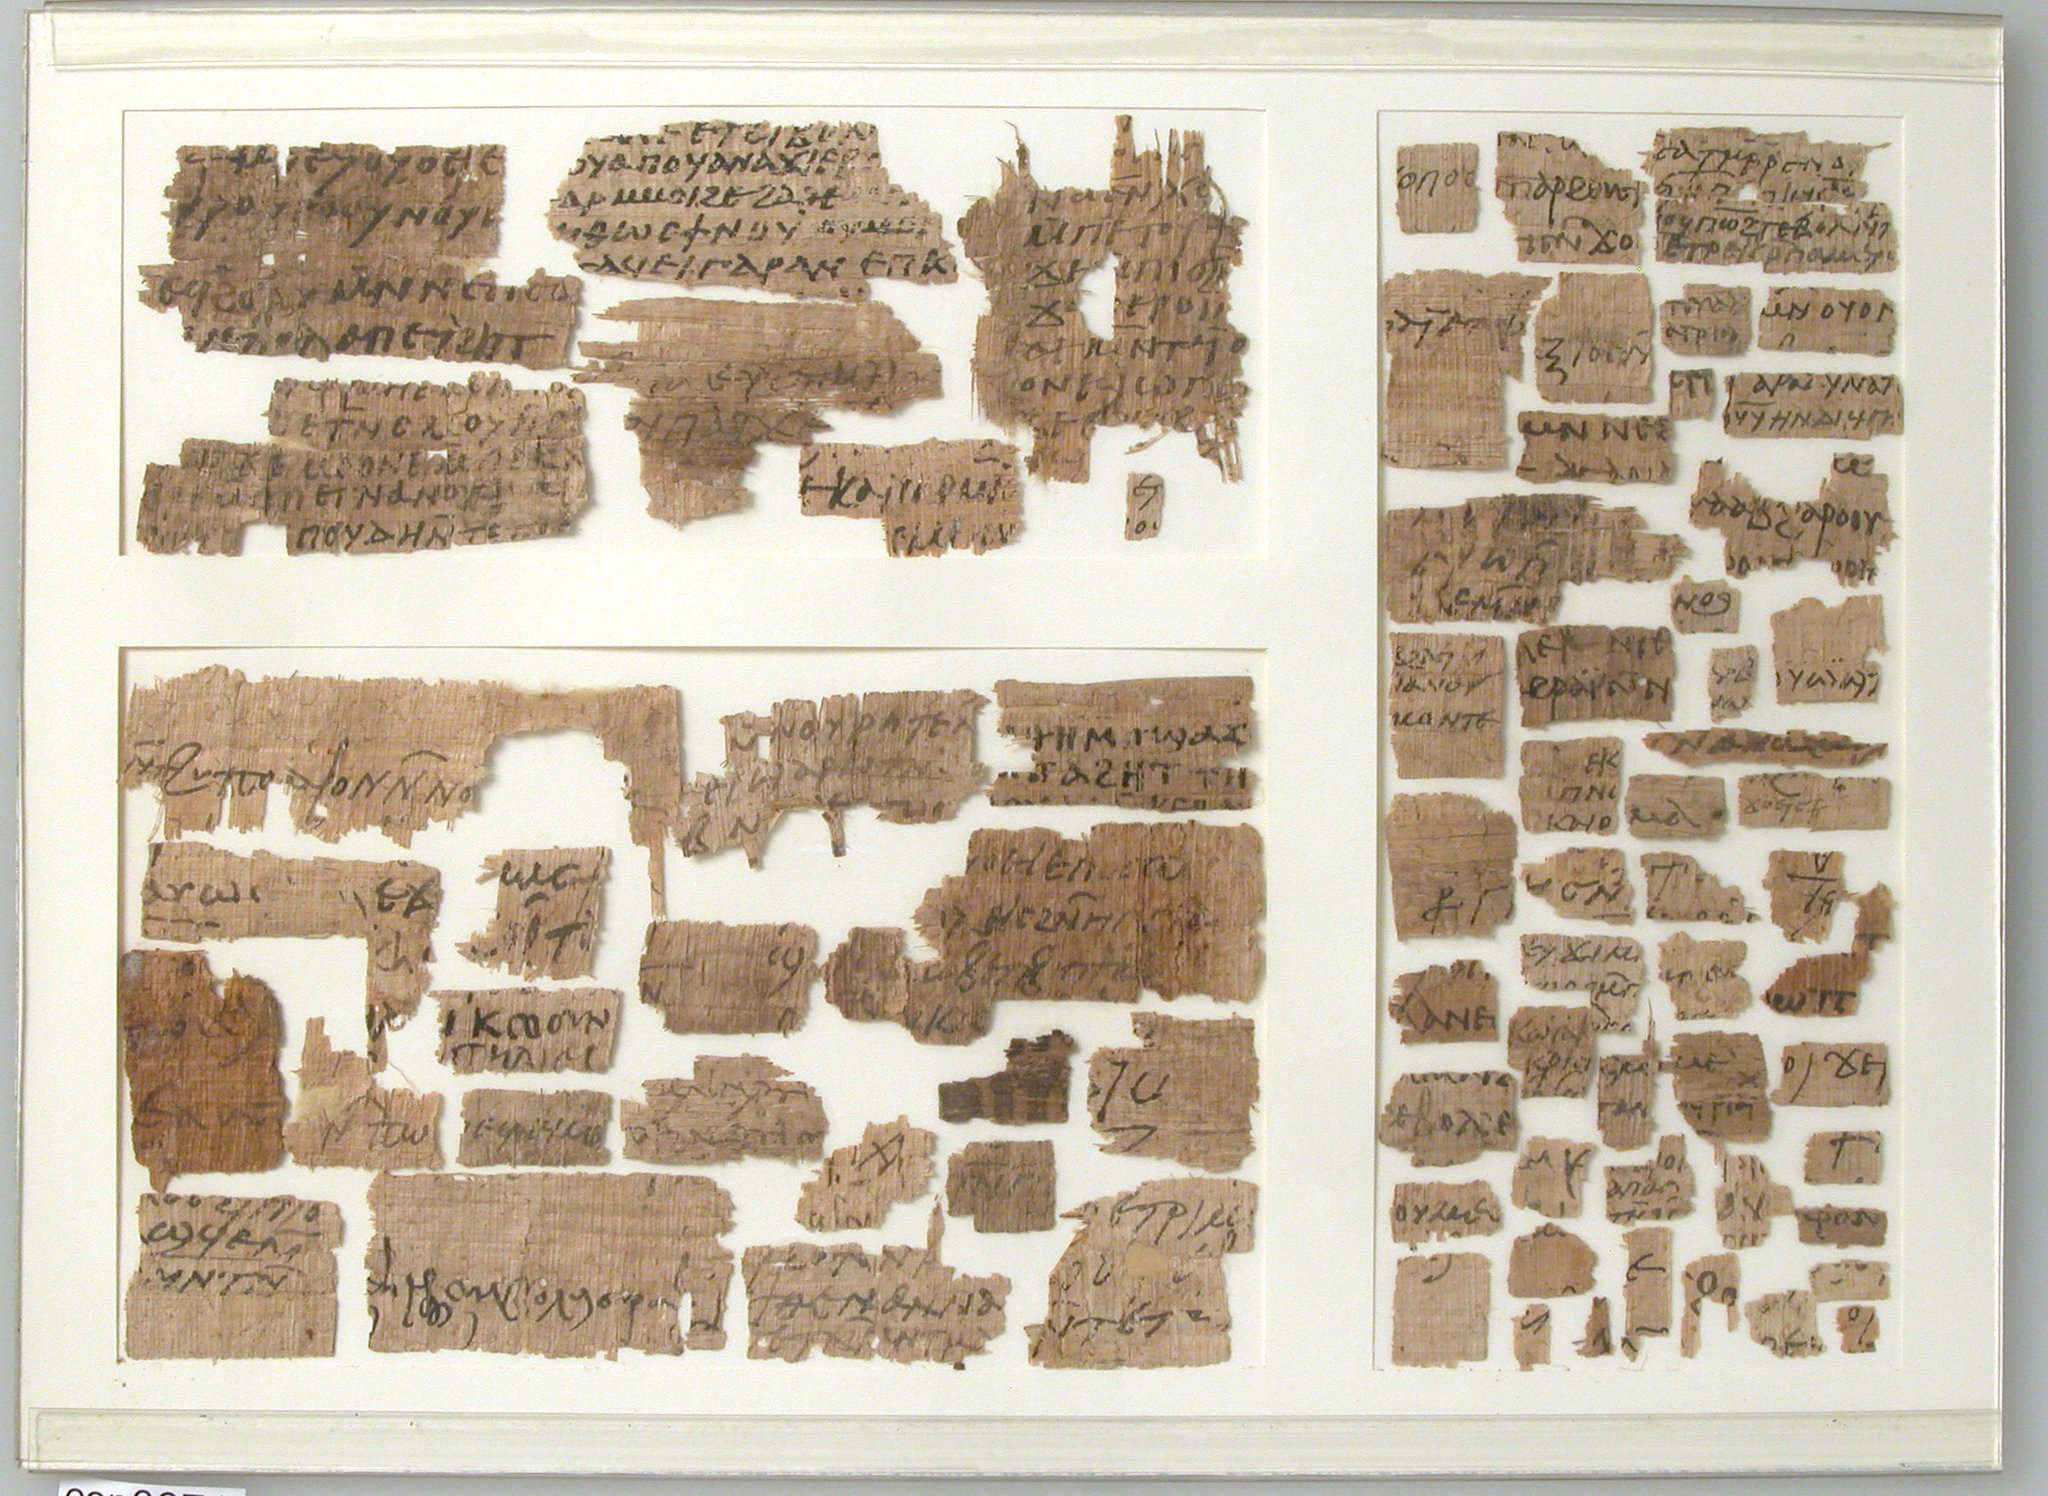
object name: fragment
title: Papyri Fragments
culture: coptic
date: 601-700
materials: ink, papyrus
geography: egypt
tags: documents